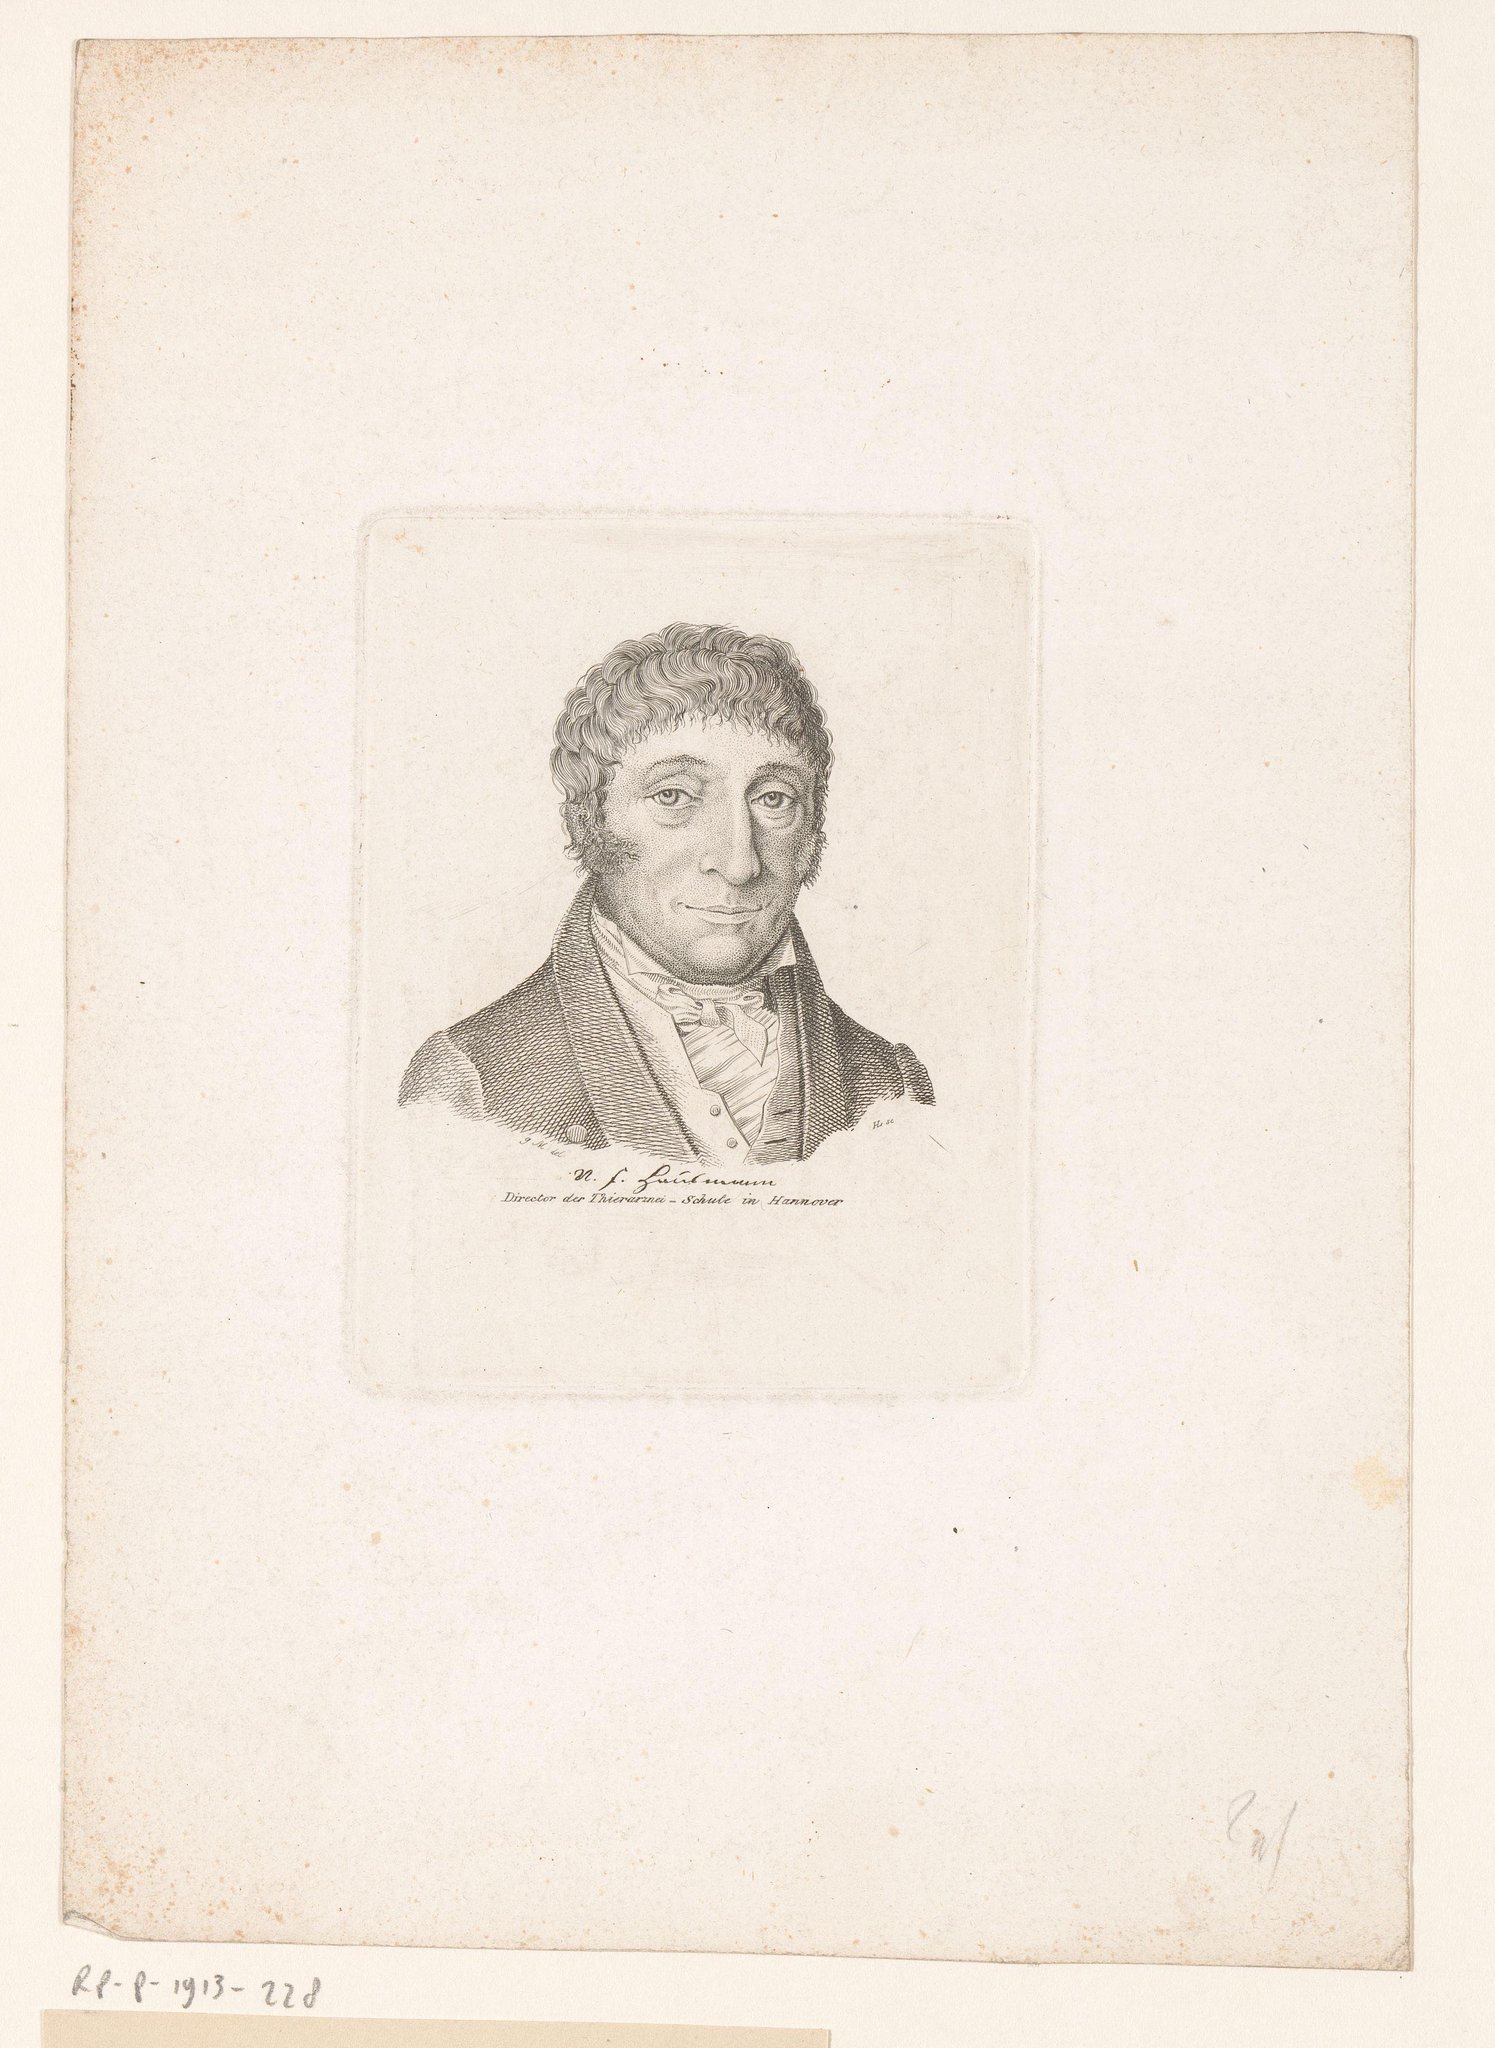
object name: print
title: Portret van A.F. Hausmann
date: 1808-1861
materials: paper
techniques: engraving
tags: historical persons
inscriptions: collector's mark: Lugt 2228